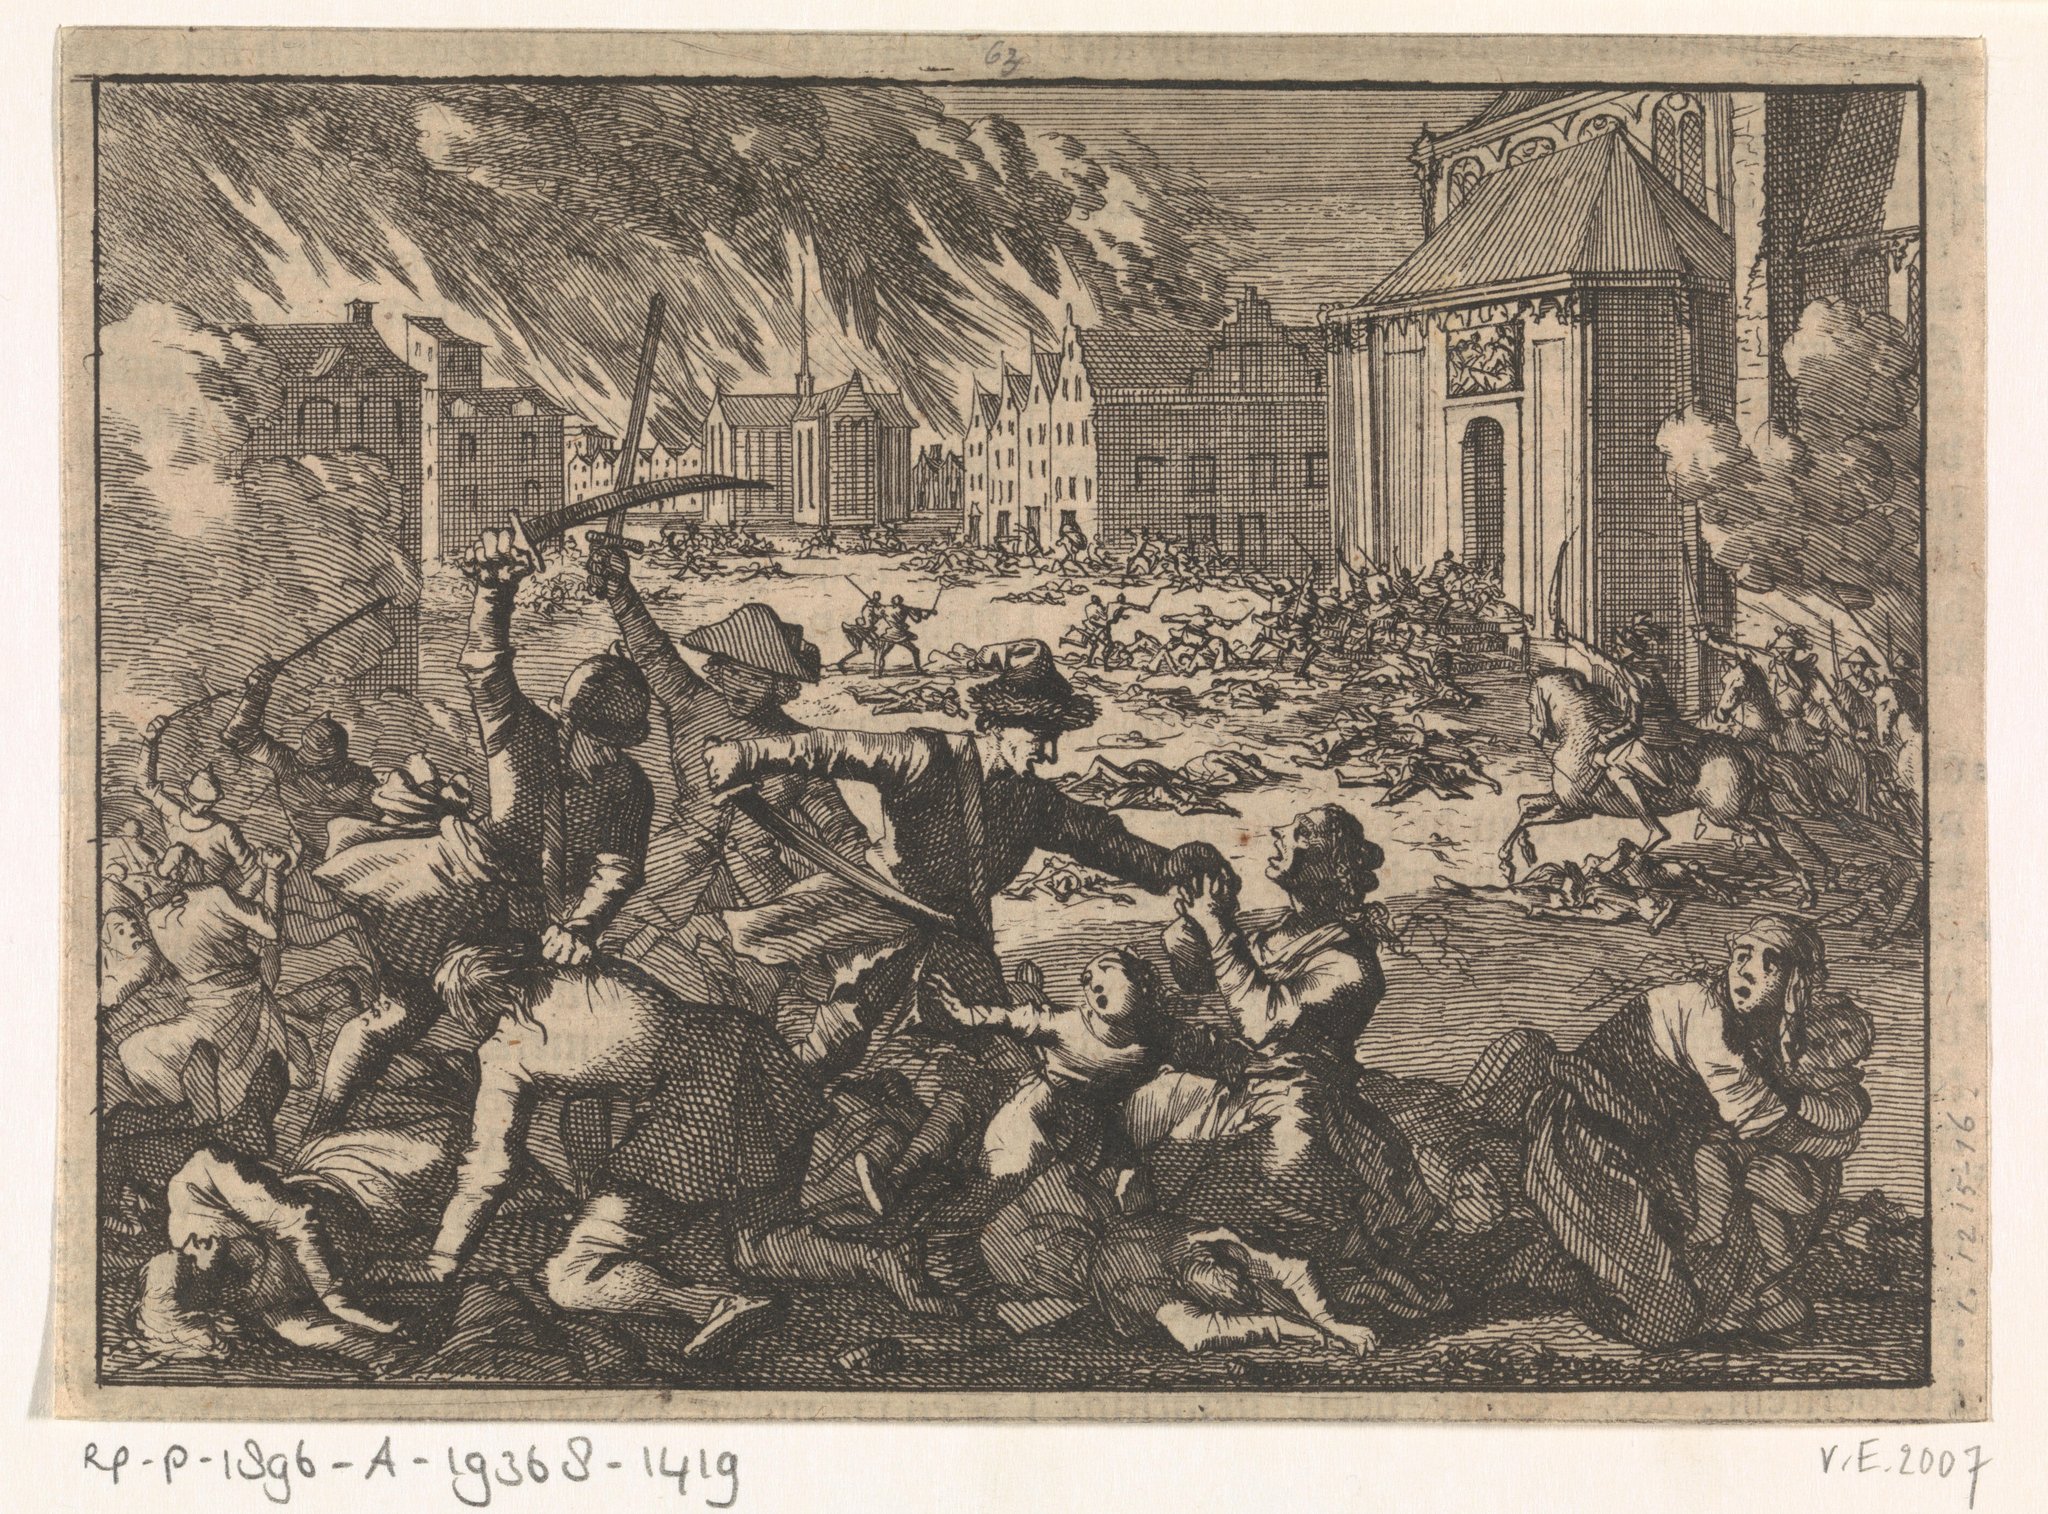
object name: print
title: Maagdenburg door Tilly veroverd terwijl weerloze burgers worden afgeslacht, 1631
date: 1698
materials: paper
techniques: etching, letterpress printing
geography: amsterdam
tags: capture of city (after the siege), murder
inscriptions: collector's mark: Lugt 2228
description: Illustratie uit: Gottfried, Johann Ludwig. Historische kronyck; vervattende een (...) beschrijvingh der aldergedenckwaerdigste geschiedenissen des weerelds, van den aenvangh der scheppingh tot (...) 1576 (2 delen). Leiden: Pieter van der Aa, 1698, dl. I, p. 1215.